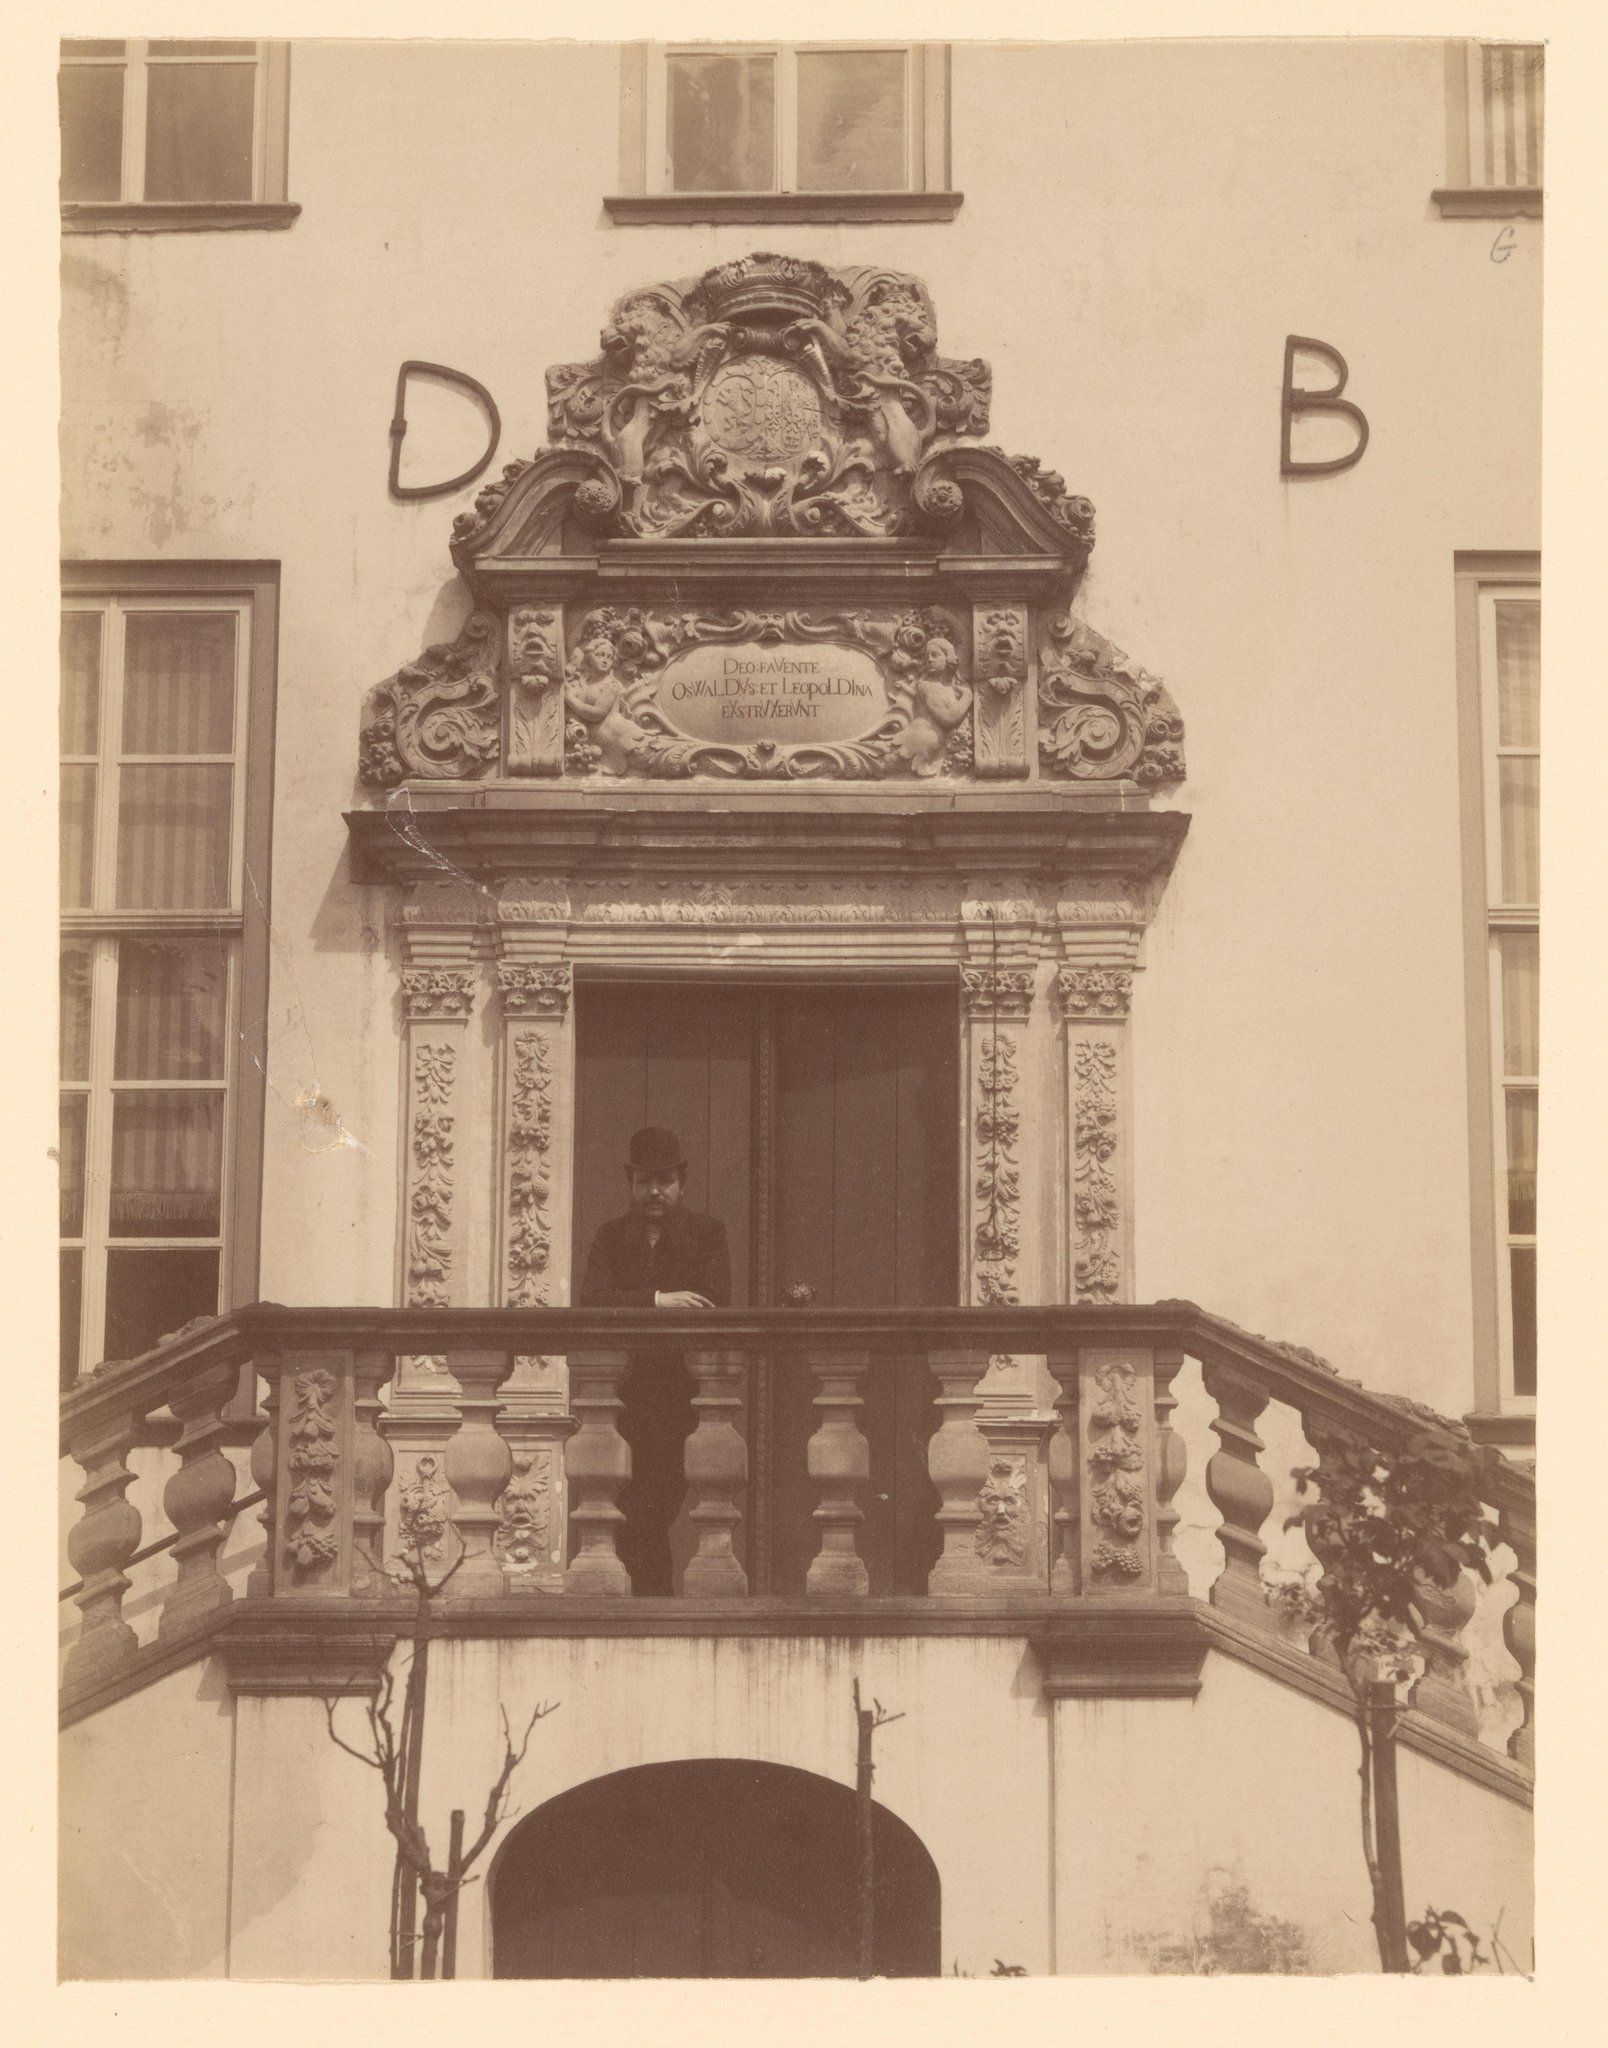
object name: photograph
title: Ingang van het Huis Bergh te 's Heerenberg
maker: anoniem (monumentenzorg)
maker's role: fotograaf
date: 1890-1920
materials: cardboard, photographic support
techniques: albumen print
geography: s-heerenberg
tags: castle, gate, entrance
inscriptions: annotation: ‘G’, annotation: ‘Kasteel te 's Heerenberg/ Hoofdtrap en ingang’